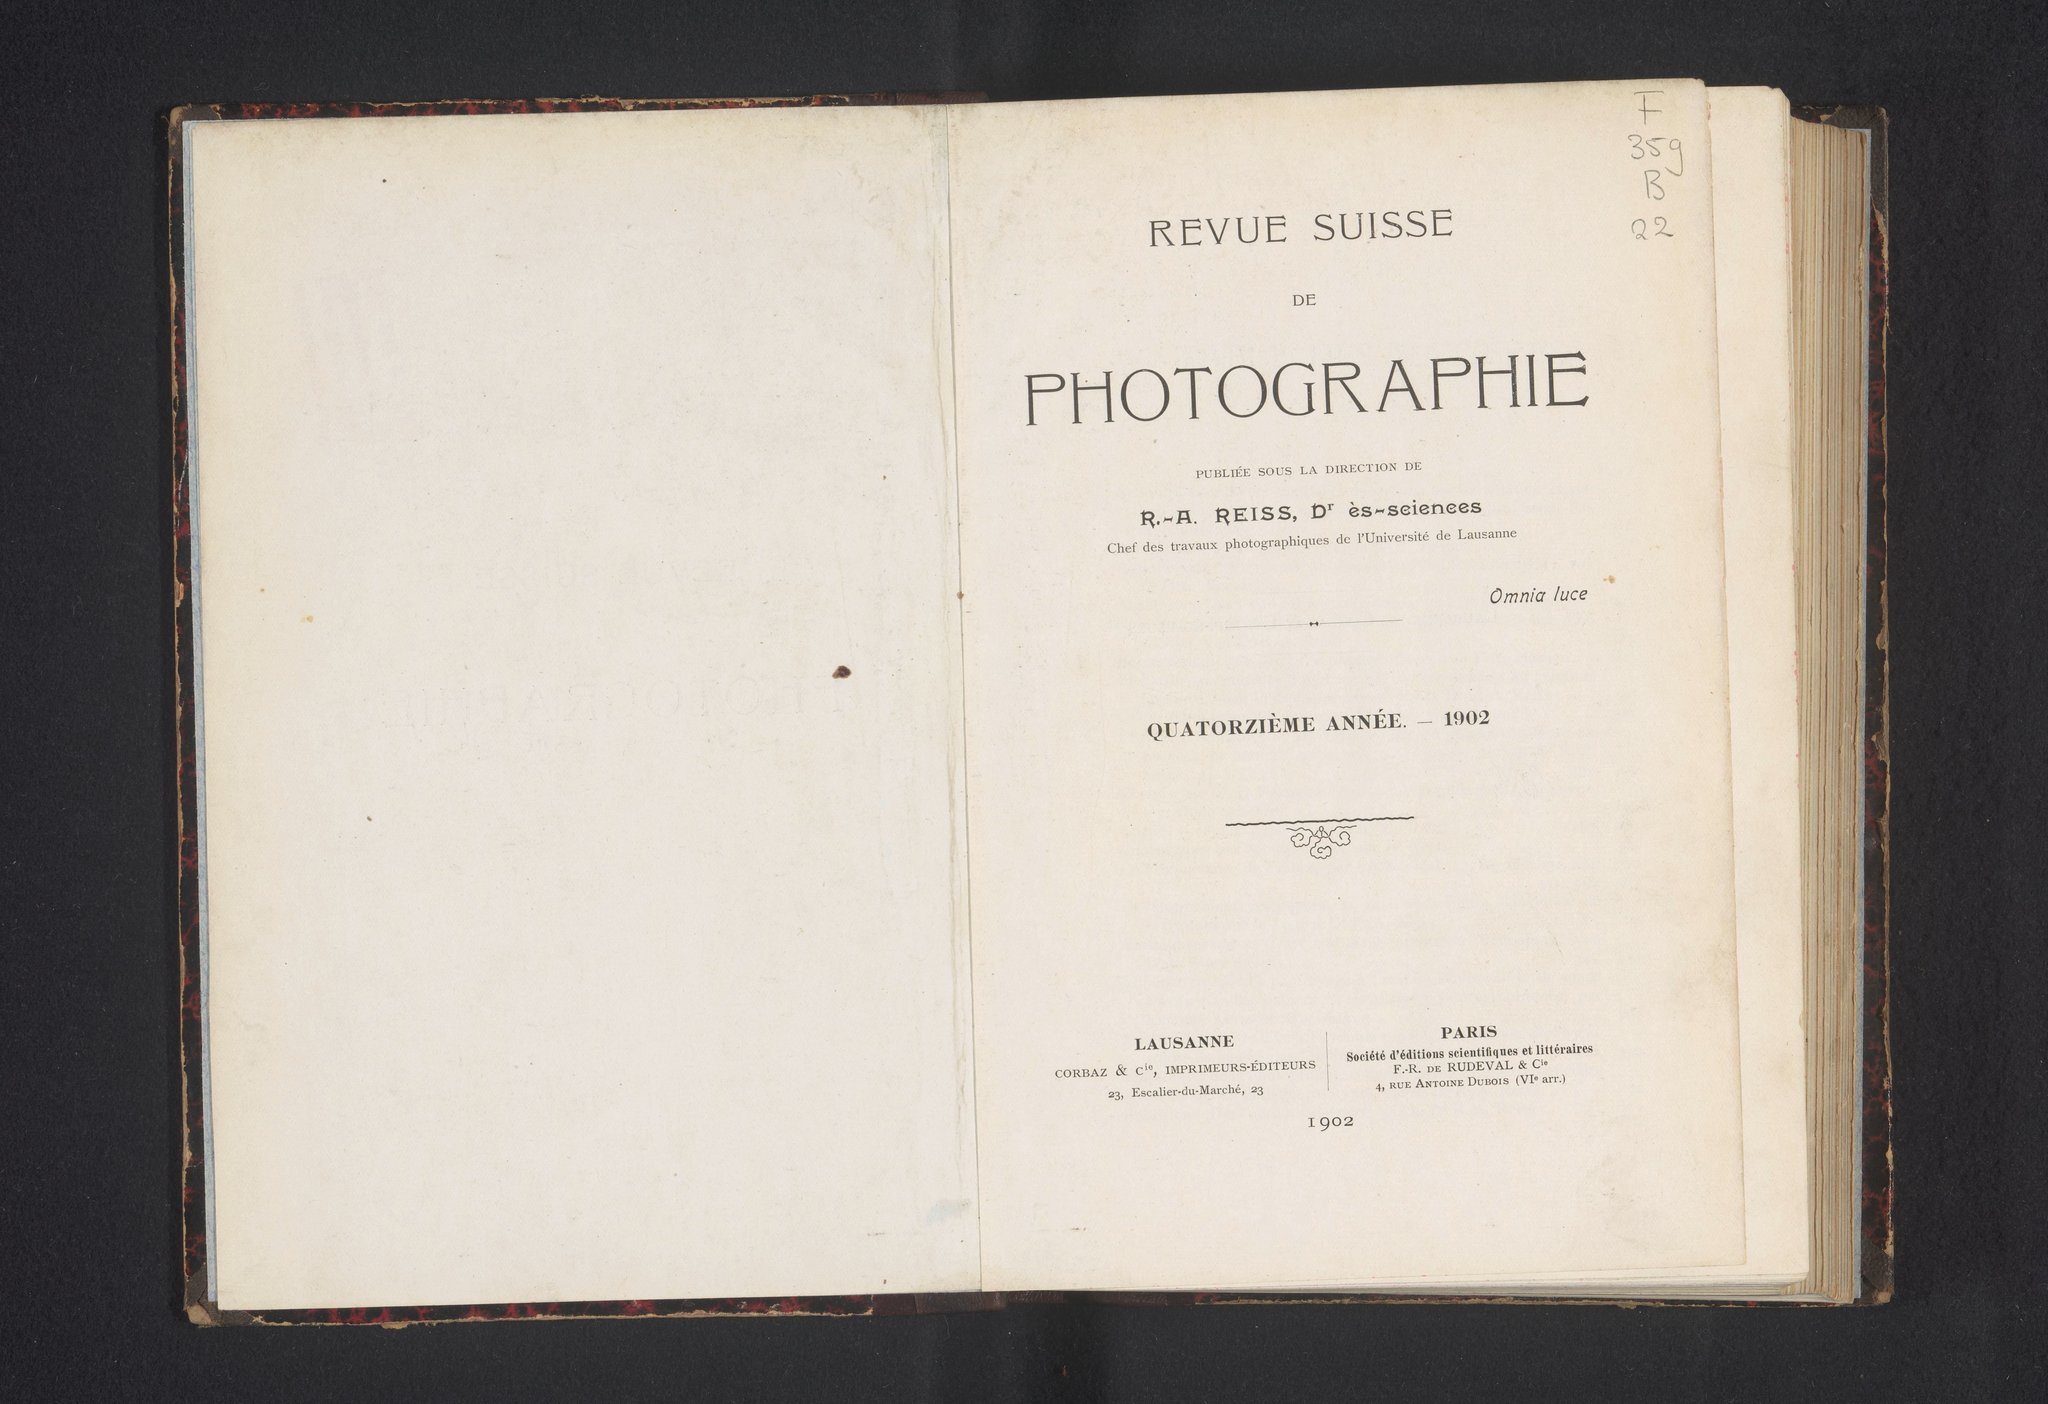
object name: book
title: Revue suisse de photographie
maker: rodolphe archibald reiss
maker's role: criminoloog, fotograaf, professor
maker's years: 1875-1929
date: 1902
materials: linen, paper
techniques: photograph, printing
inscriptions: collector's mark: ‘Dr. Frans de vos/ 64 tot Rivierenlaan, 64/ Deurne/ [...]’